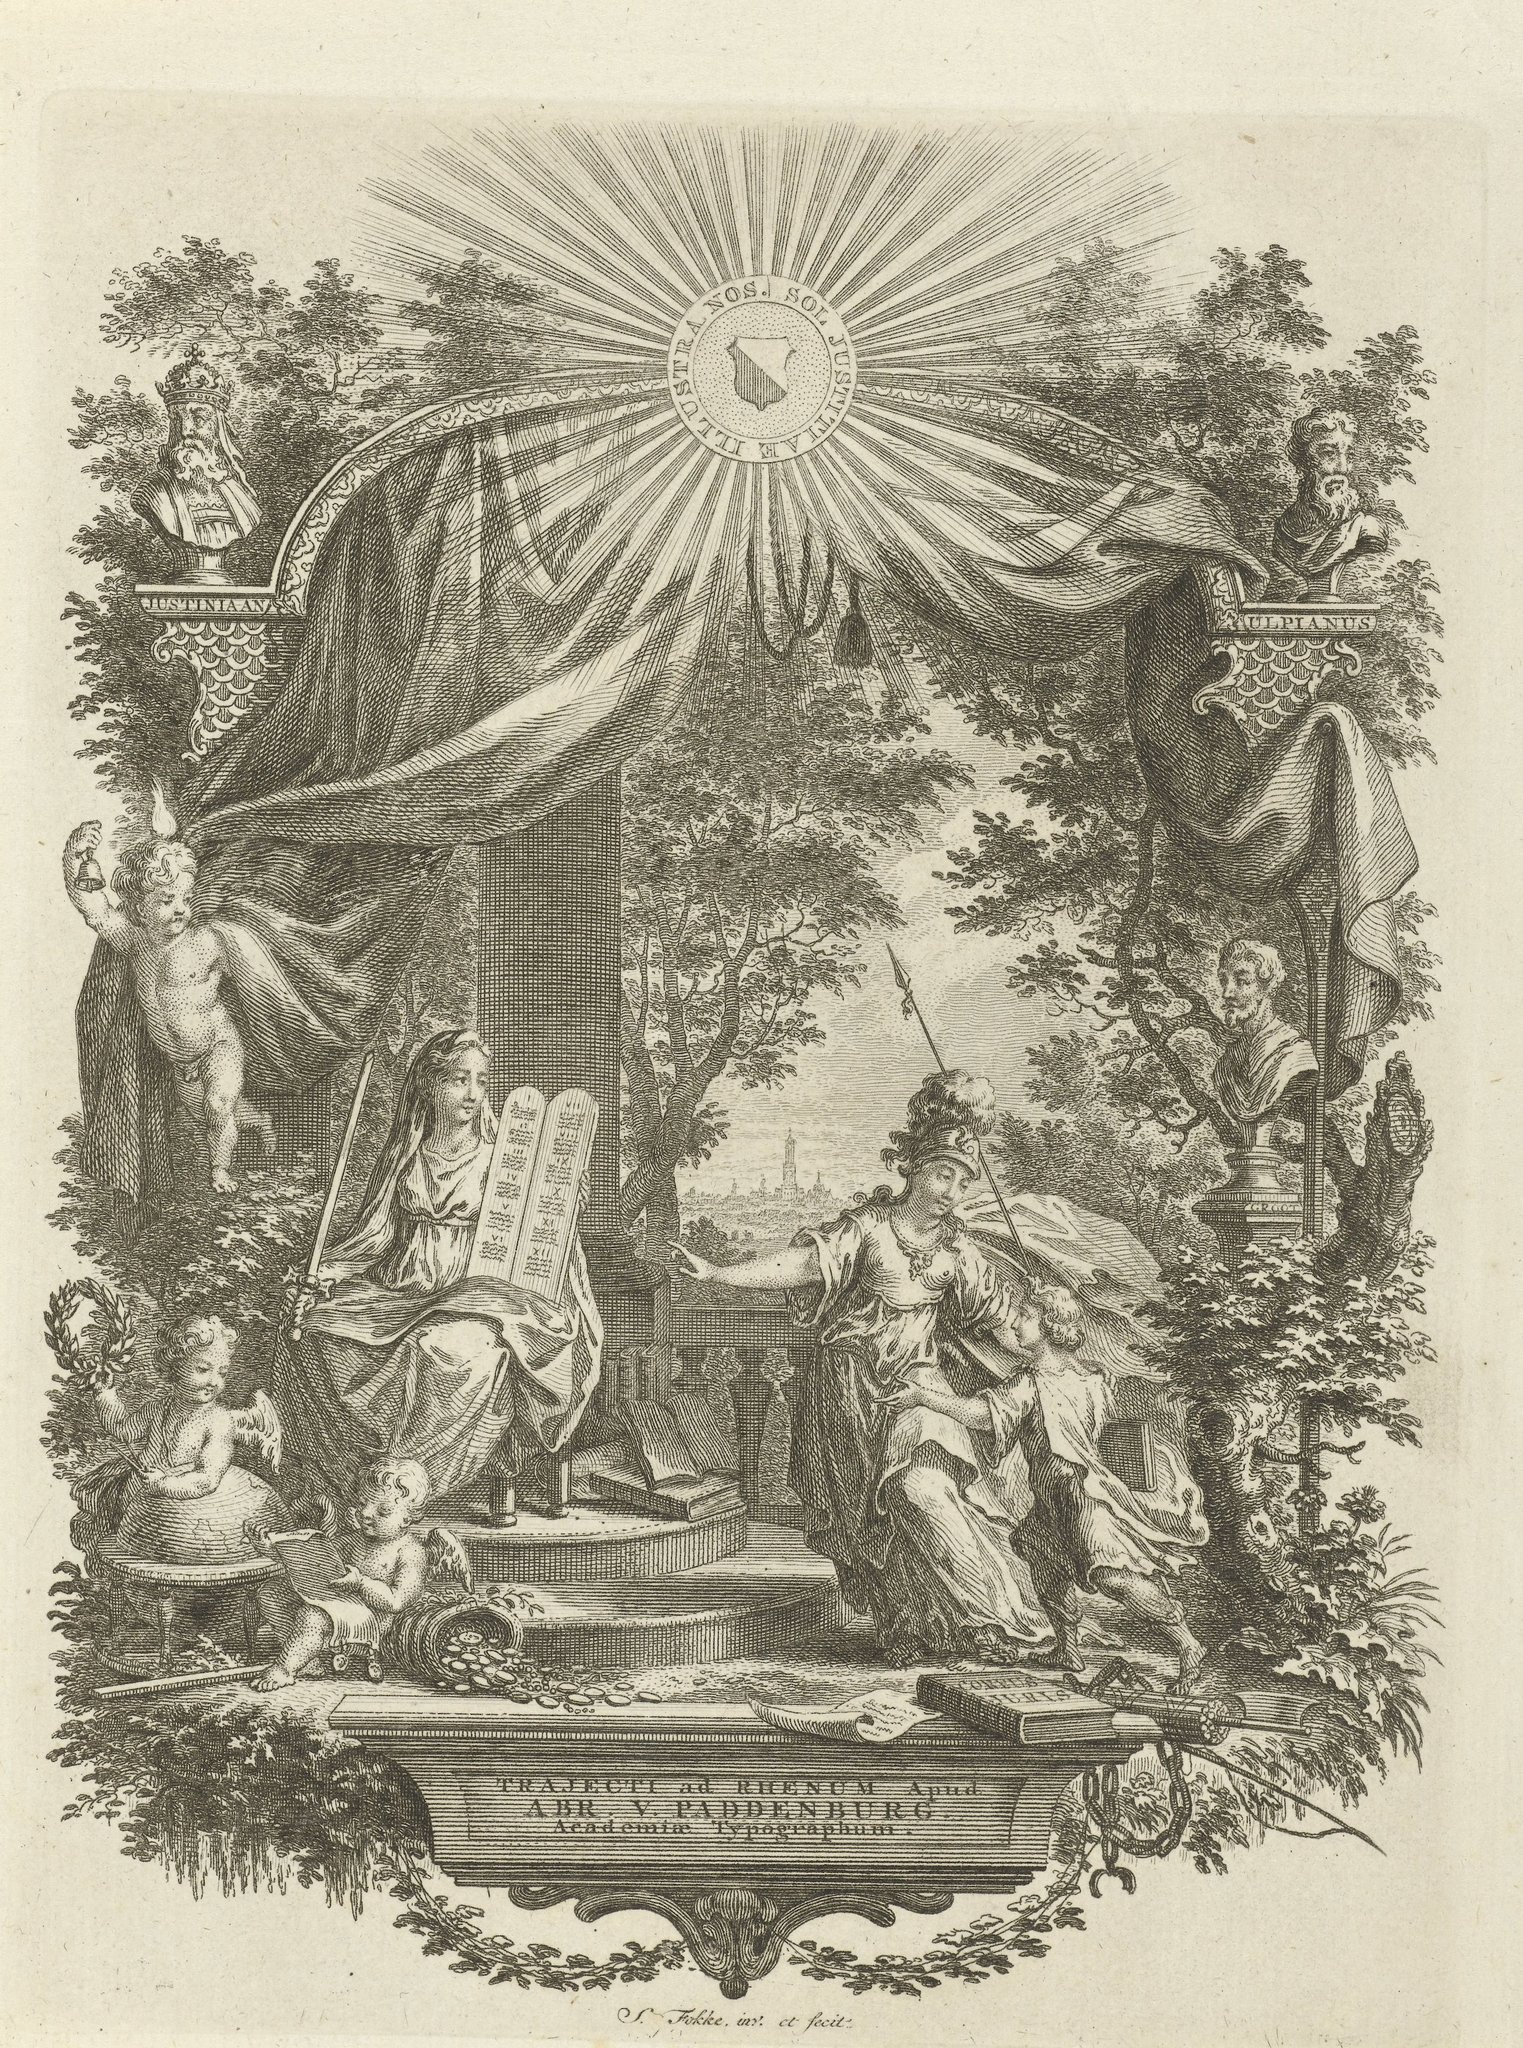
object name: print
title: Minerva ontvangt een jongeman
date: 1750-1790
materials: paper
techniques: etching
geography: amsterdam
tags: (story of) minerva (pallas, athena), historical persons (+ (full) bust portrait), cupids: 'amores', 'amoretti', 'putti'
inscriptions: collector's mark: Lugt 2228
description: Minerva ontvangt een jongeman en leidt hem richting de personificatie van Gods geboden. Boven haar vliegt een putto met een vlammetje boven het hoofd en een bel in de hand. Aan haar voeten steunt een lezende putto tegen een hoorn des overvloed en staat een putto met lauwerkrans bij een wereldbol. Links van Minerva staat een portretbuste van Hugo de Groot. De voorstelling wordt gekroond door een wapen met rondom de tekst: Illustra nos sol justitiae. Links en rechts hiervan borstbeelden van Justinianus en Ulpianus.